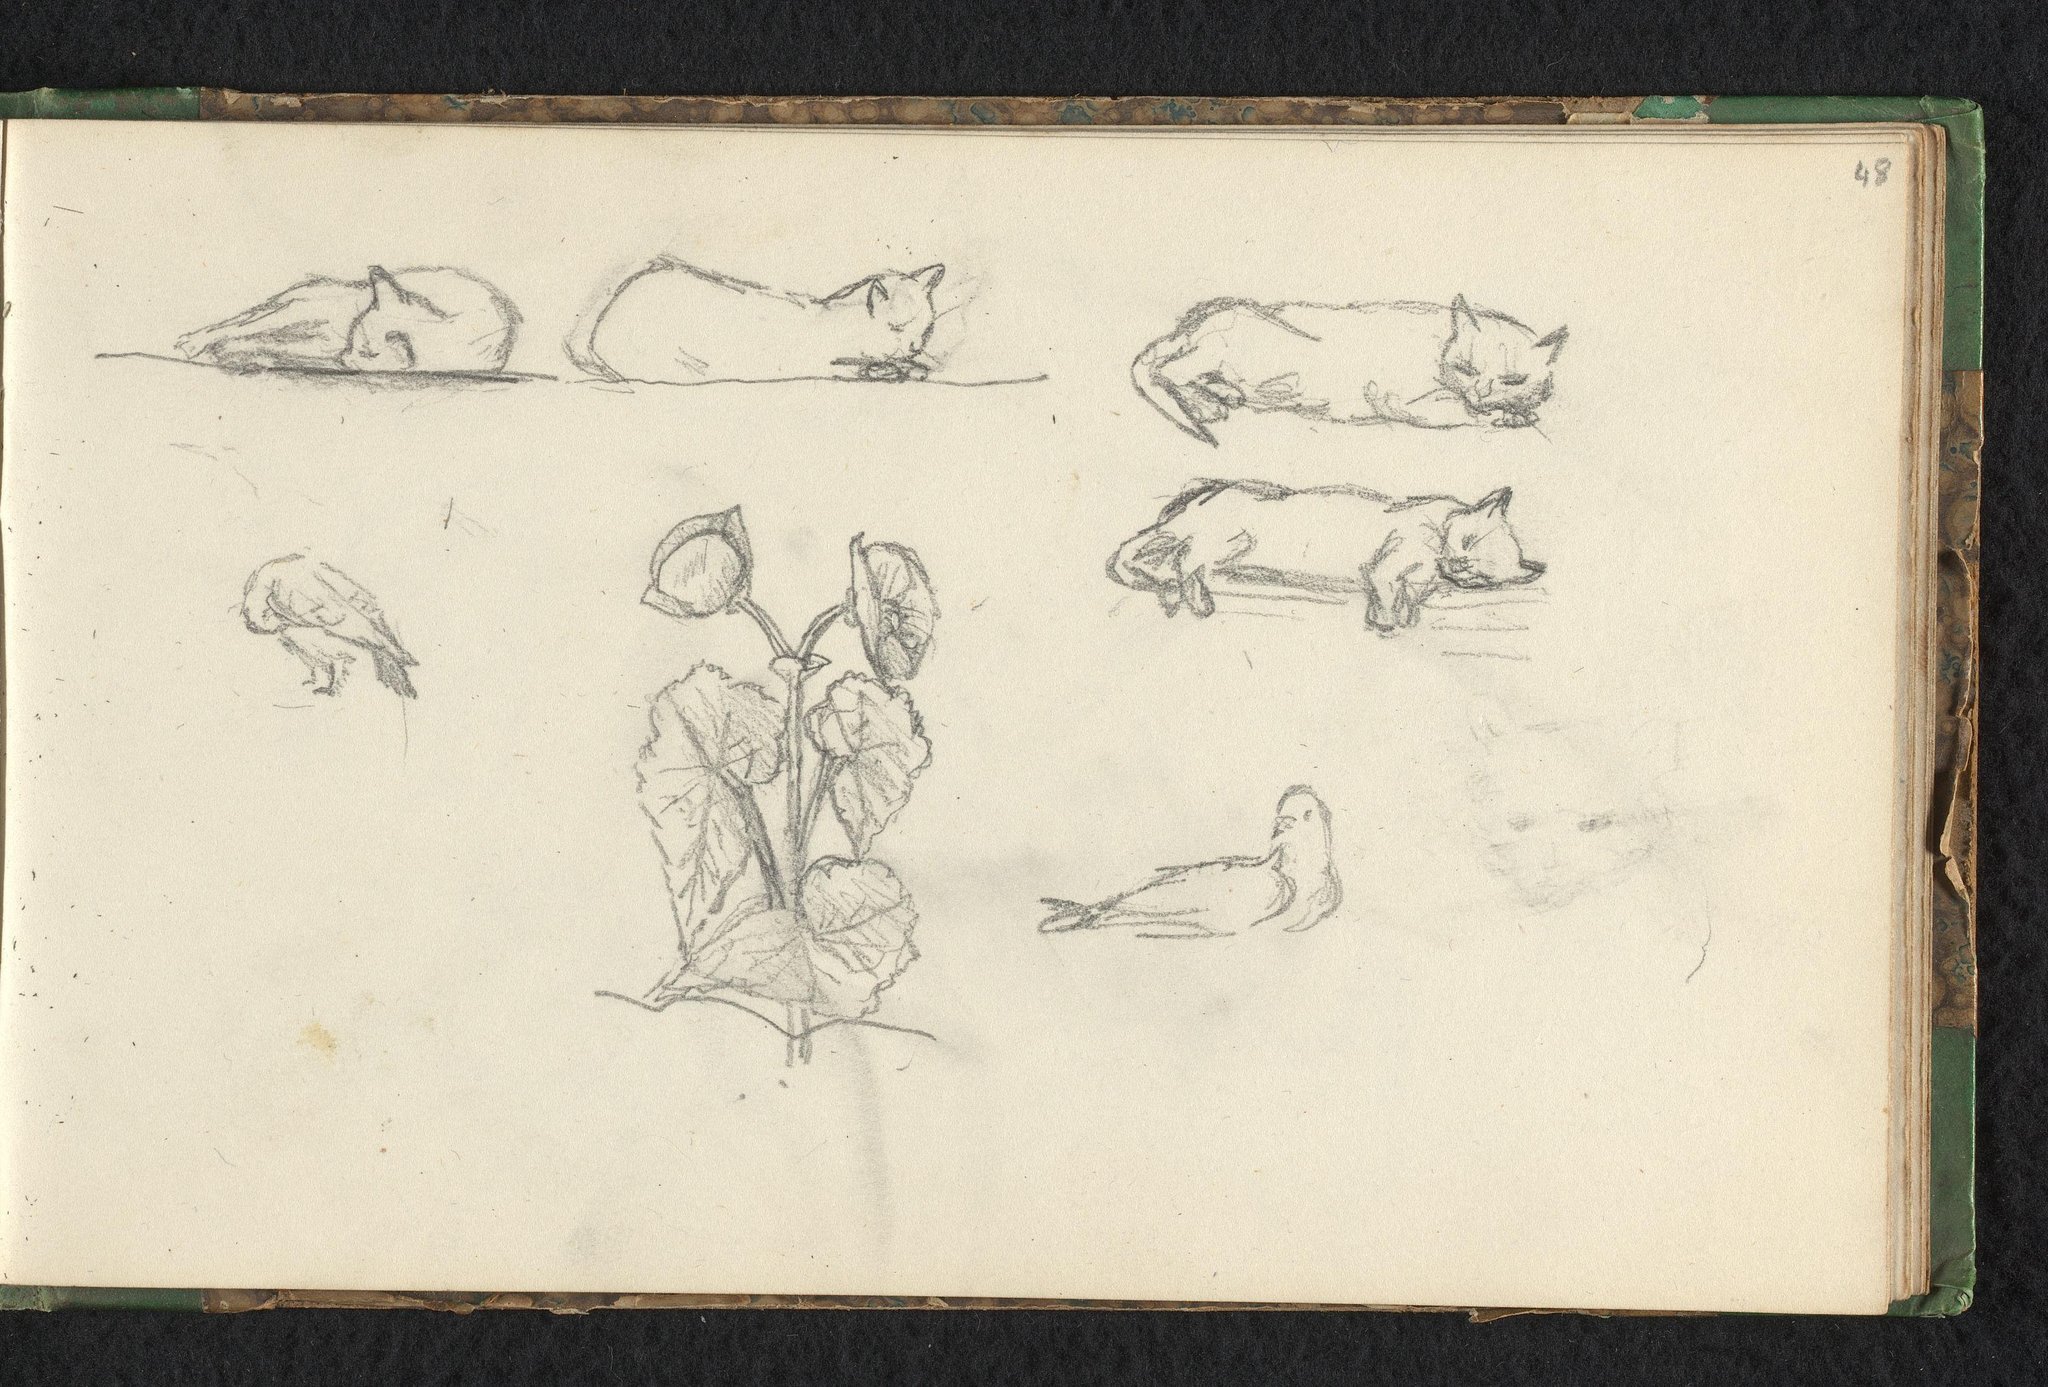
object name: sketchbook leaf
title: Vier katten, twee duiven en bloemen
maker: jan bedijs tom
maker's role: draughtsman, painter, print maker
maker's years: 1813-1894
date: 1823-1894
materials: paper, pencil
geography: the hague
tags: flowers, cat, doves, pigeons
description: Pagina 48 recto uit een schetsboek met 61 bladen.